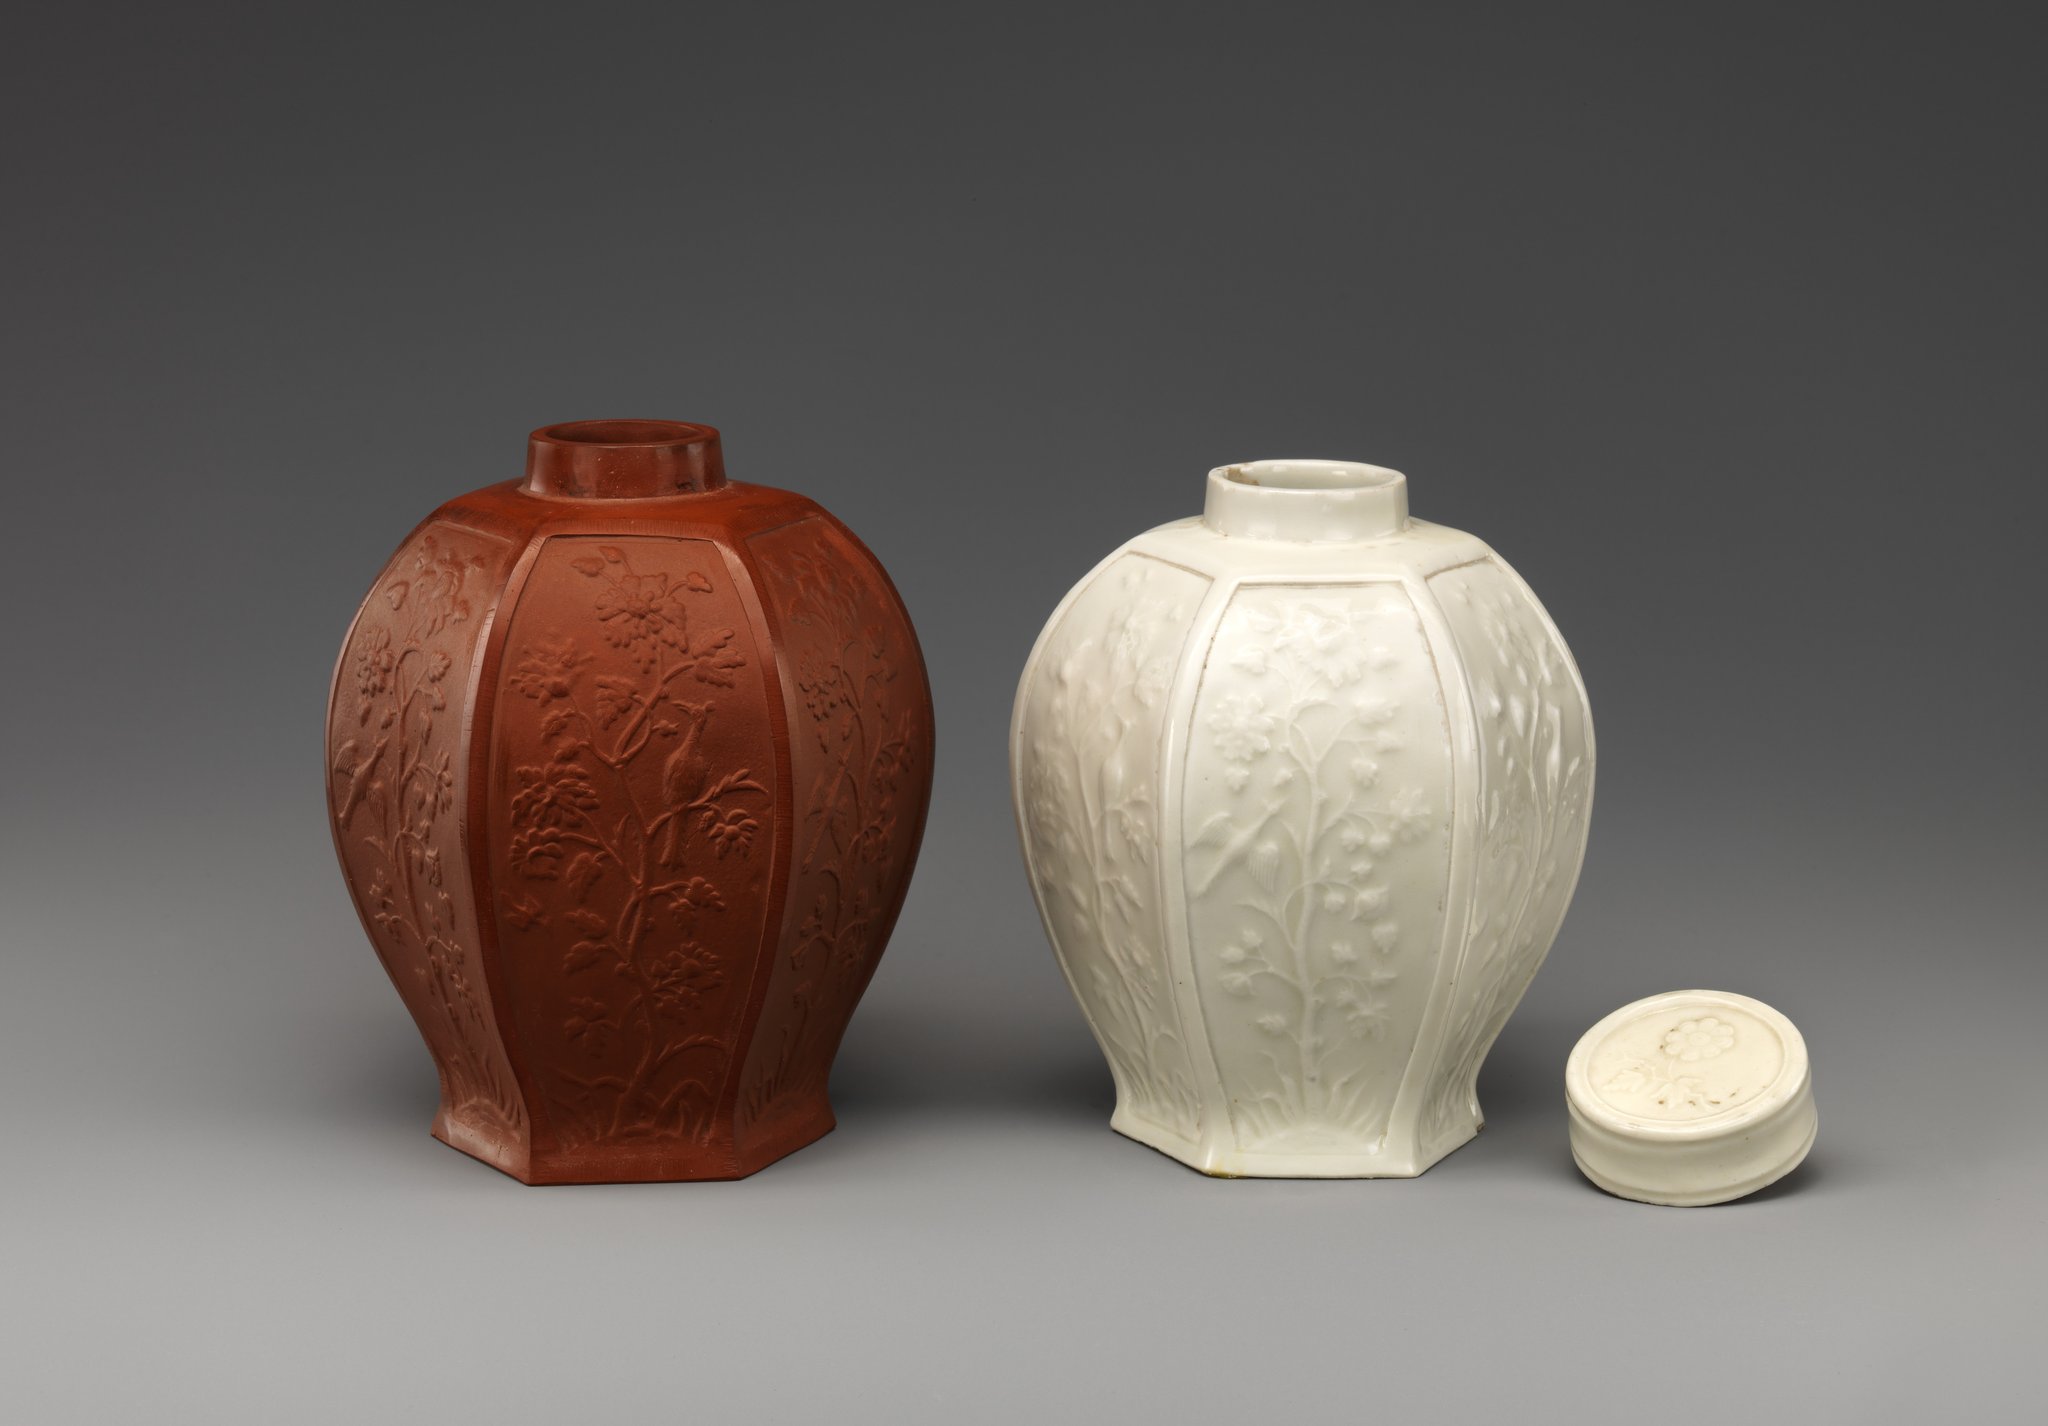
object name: tea caddy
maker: meissen manufactory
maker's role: manufactory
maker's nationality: german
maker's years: 1710-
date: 1710-1713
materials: stoneware